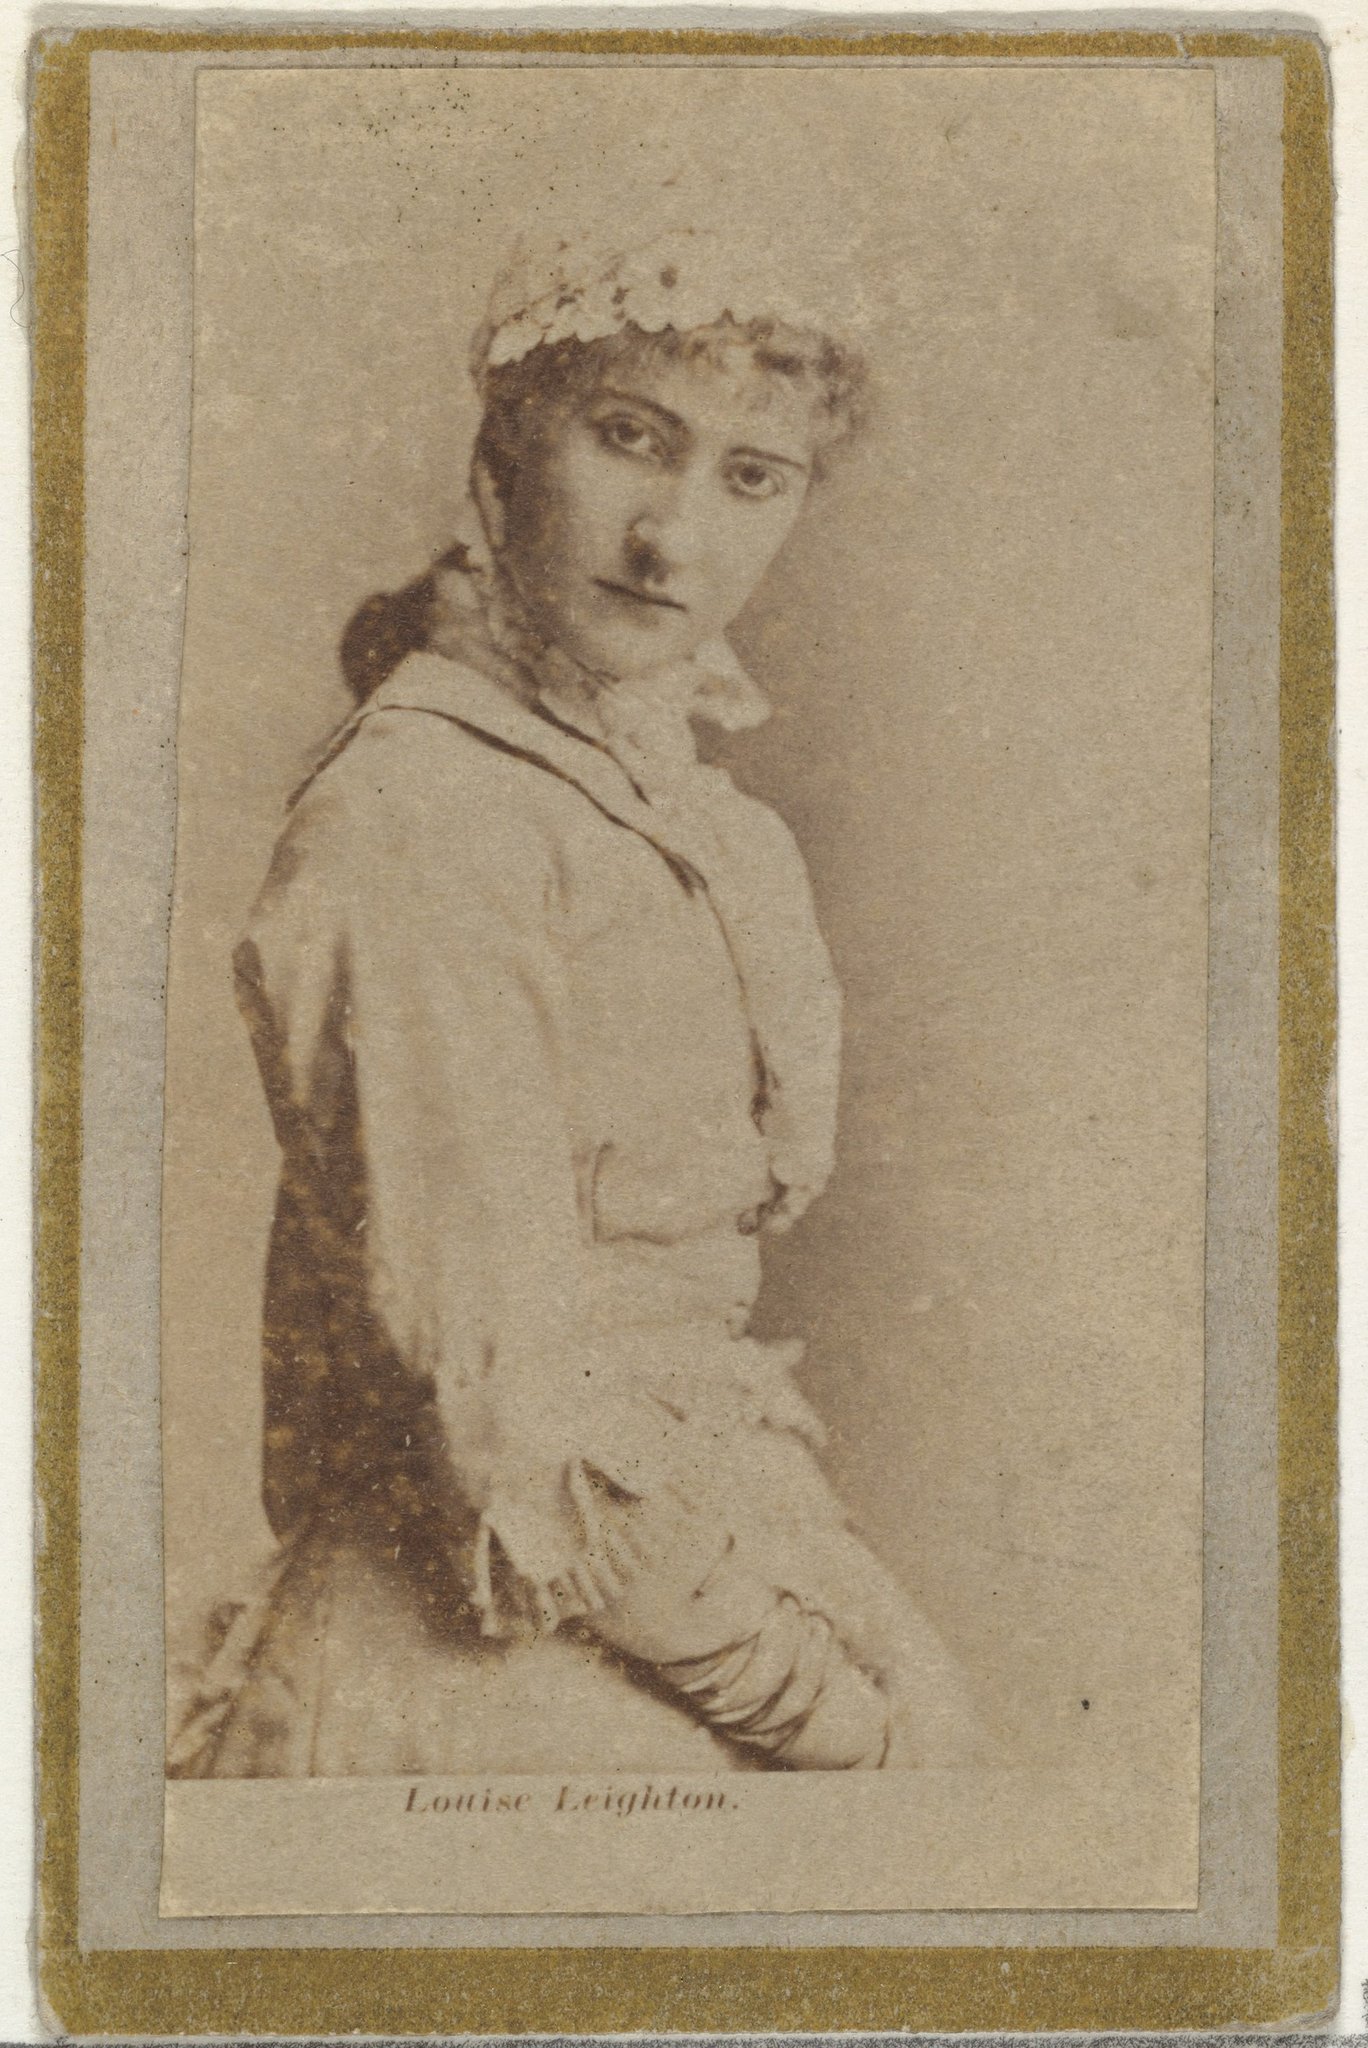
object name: photograph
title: Louise Leighton, from the Actresses and Celebrities series (N60, Type 2) promoting Little Beauties Cigarettes for Allen & Ginter brand tobacco products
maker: allen & ginter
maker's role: publisher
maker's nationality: american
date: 1887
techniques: albumen silver print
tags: portraits,women,actresses